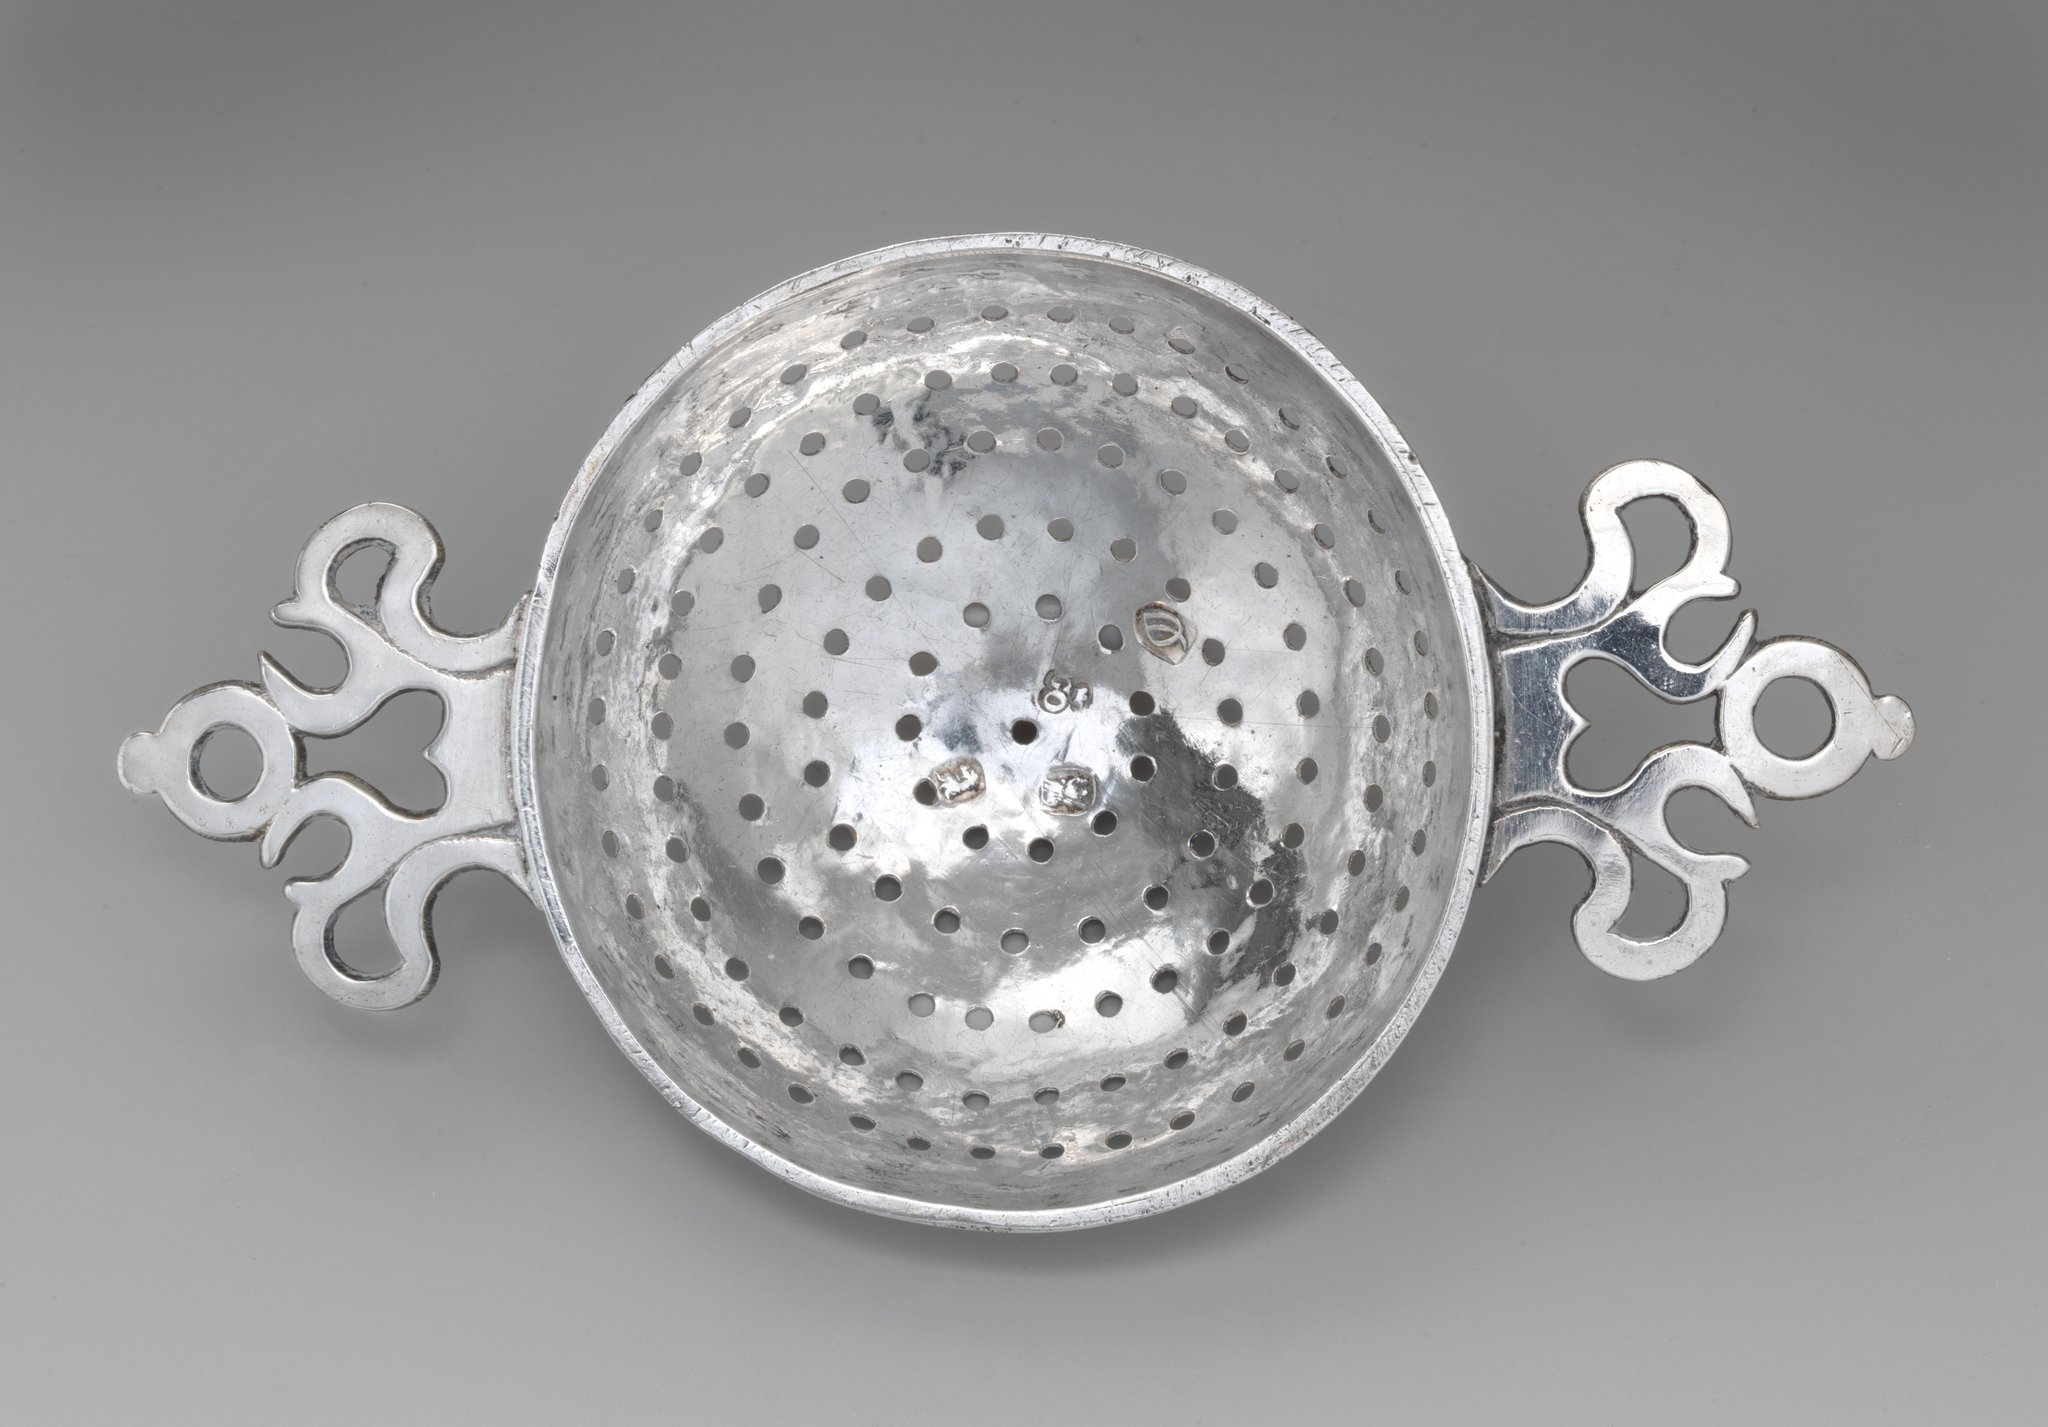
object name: orange strainer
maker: james goodwin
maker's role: maker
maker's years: 1706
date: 1713-1714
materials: silver